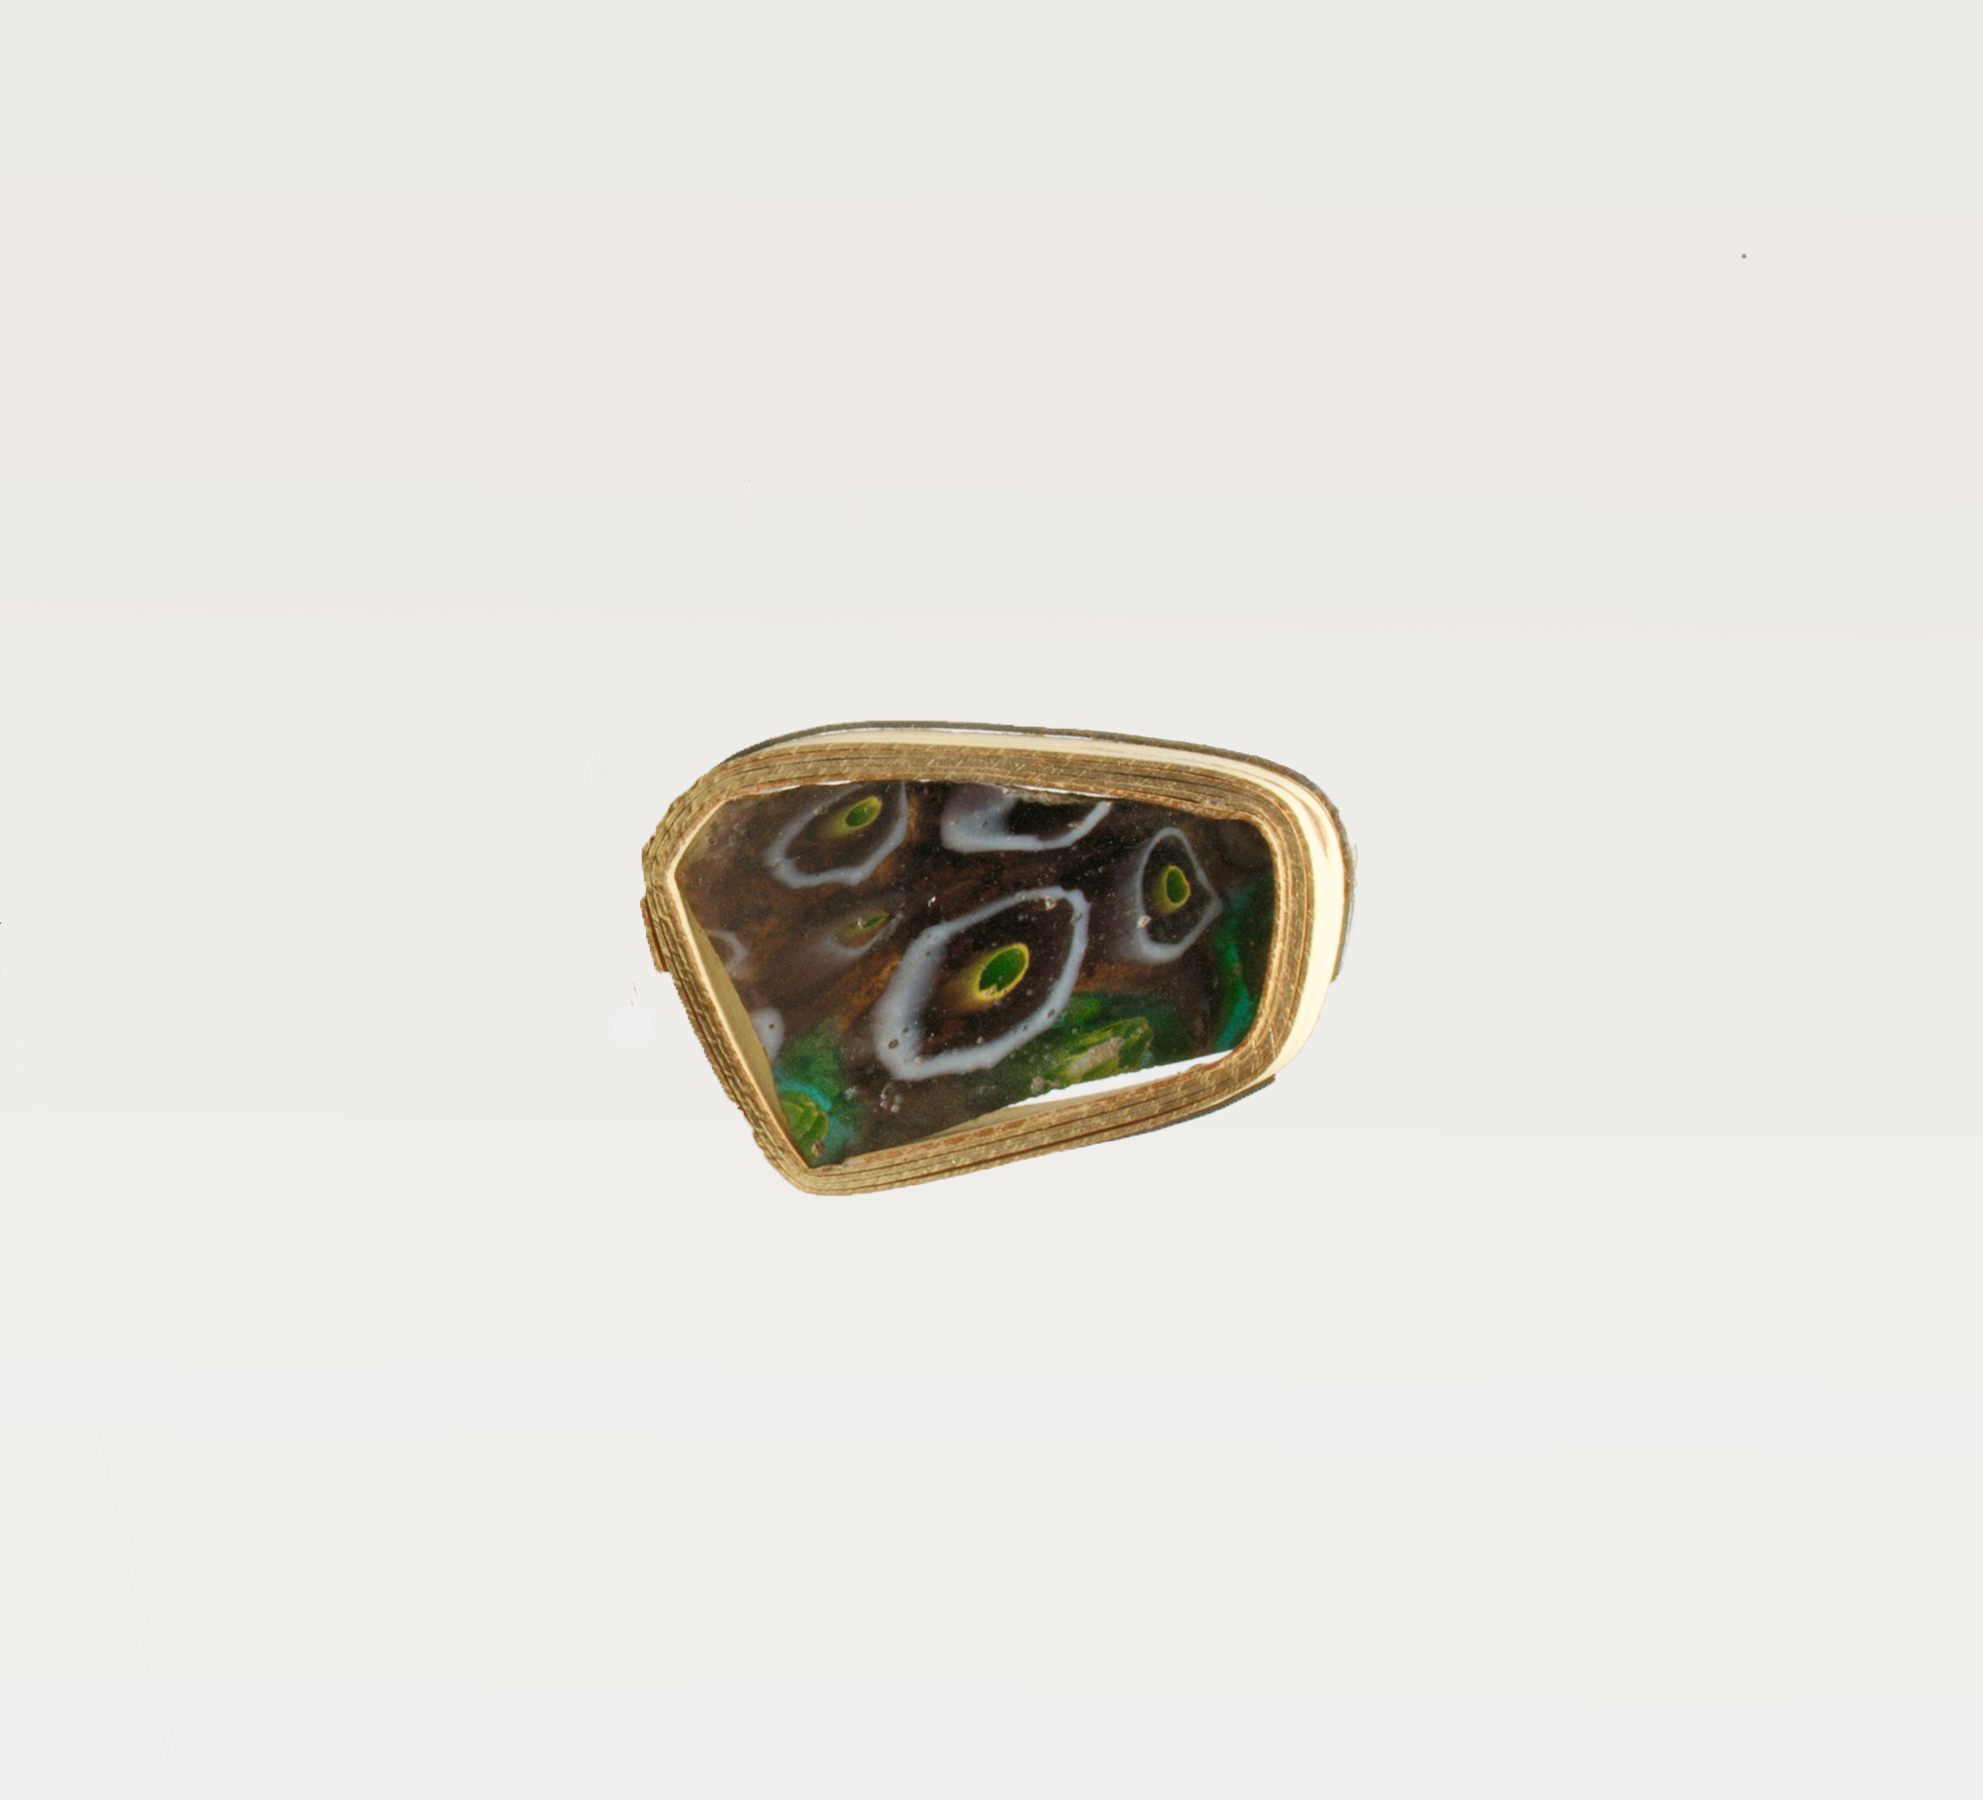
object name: fragment, mosaic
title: Glass mosaic fragment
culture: roman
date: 34 BCE-33 CE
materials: glass